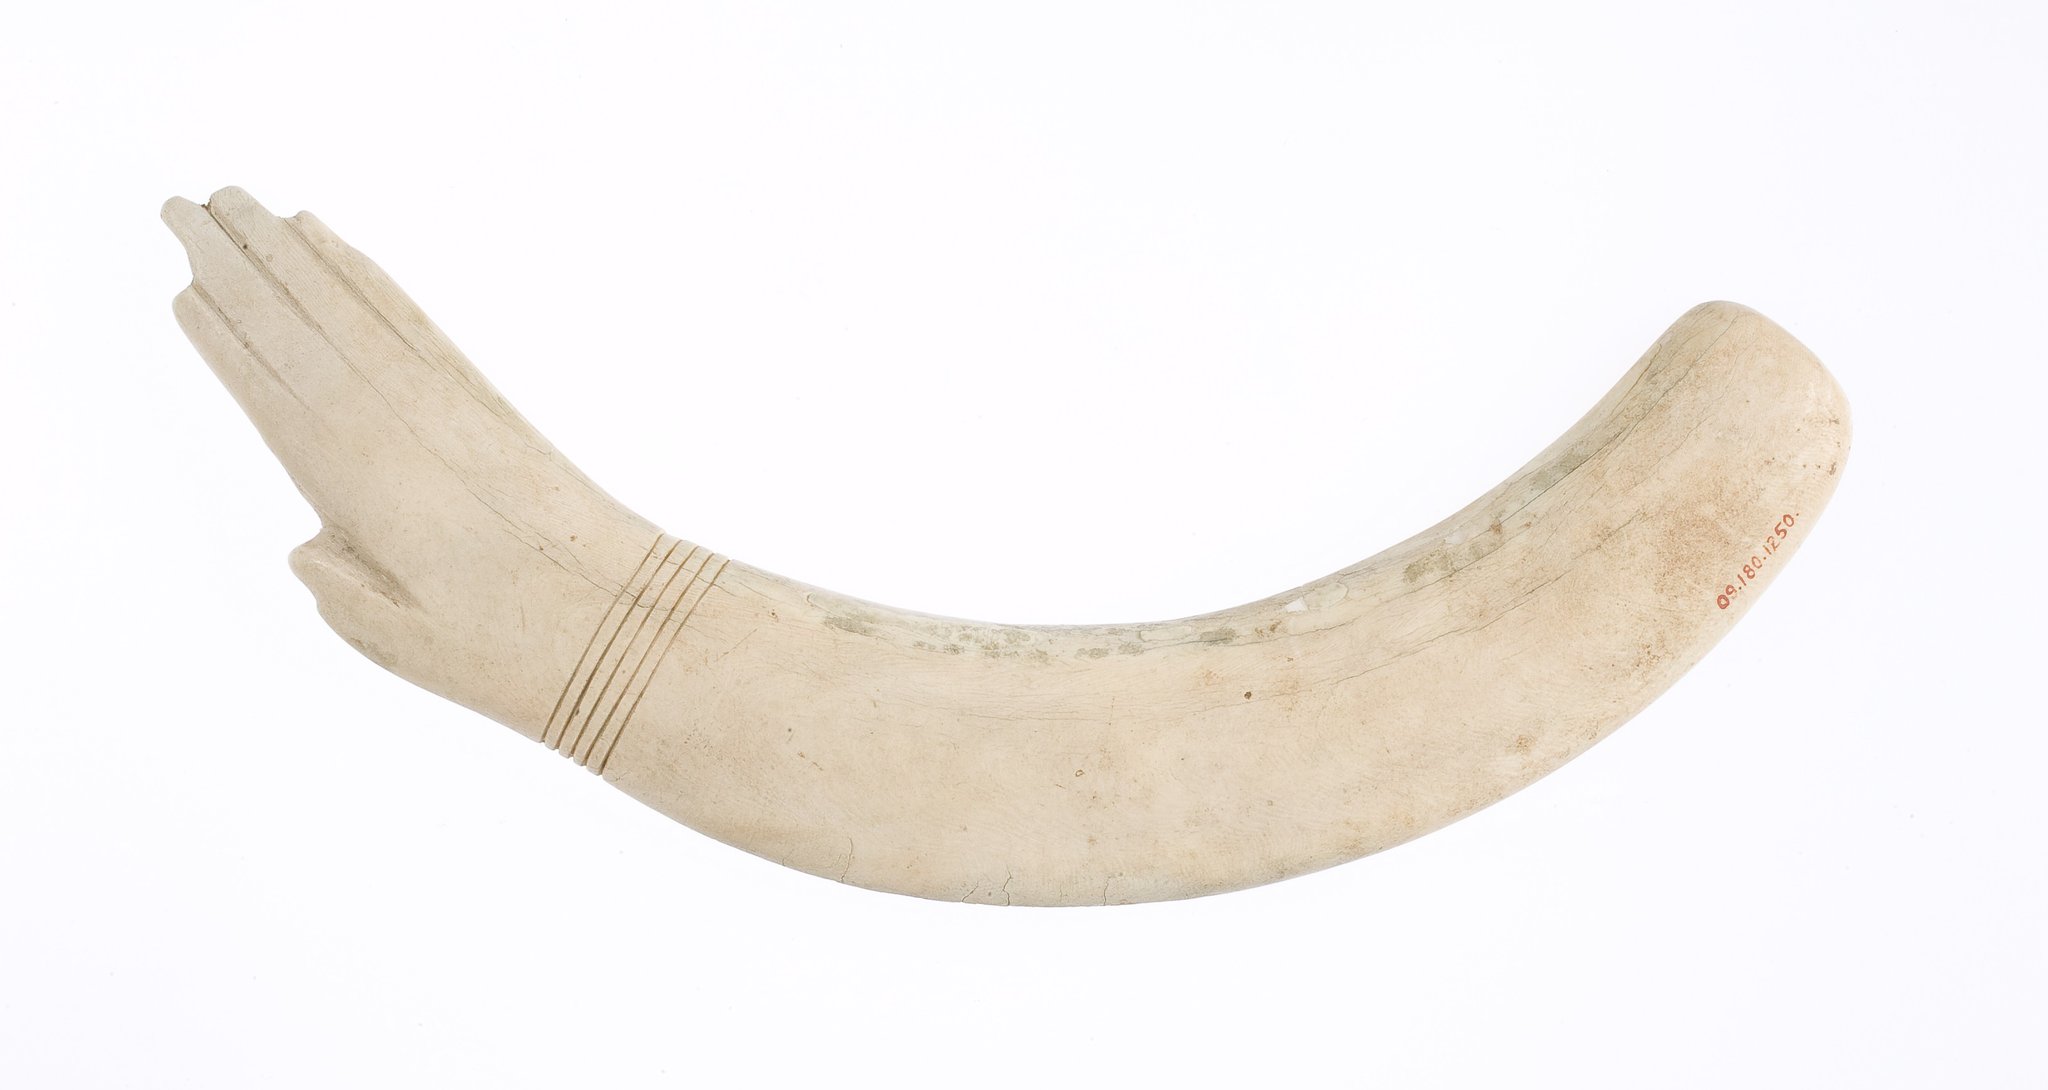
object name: music, clapper, arm, hand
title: Clapper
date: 1640-1500 BCE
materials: ivory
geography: egypt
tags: arms